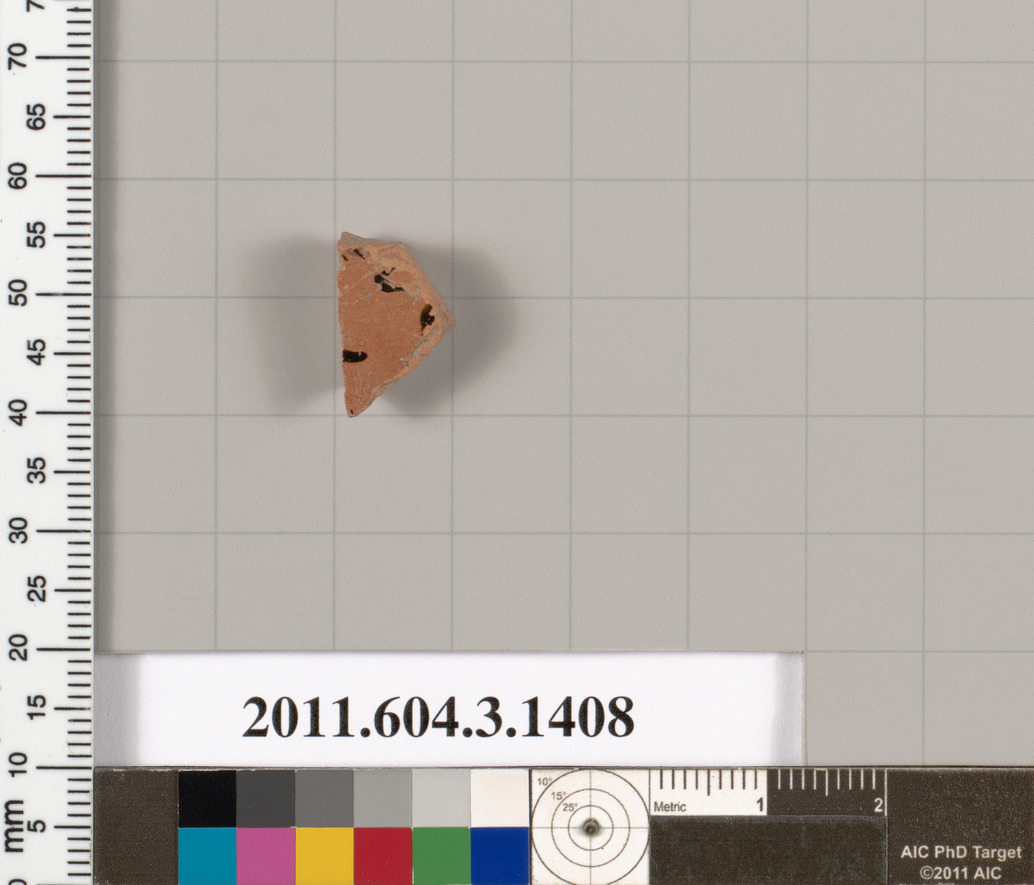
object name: skyphos fragment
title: Terracotta fragment of a skyphos (deep drinking cup)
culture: greek, attic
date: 534-468 BCE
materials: terracotta